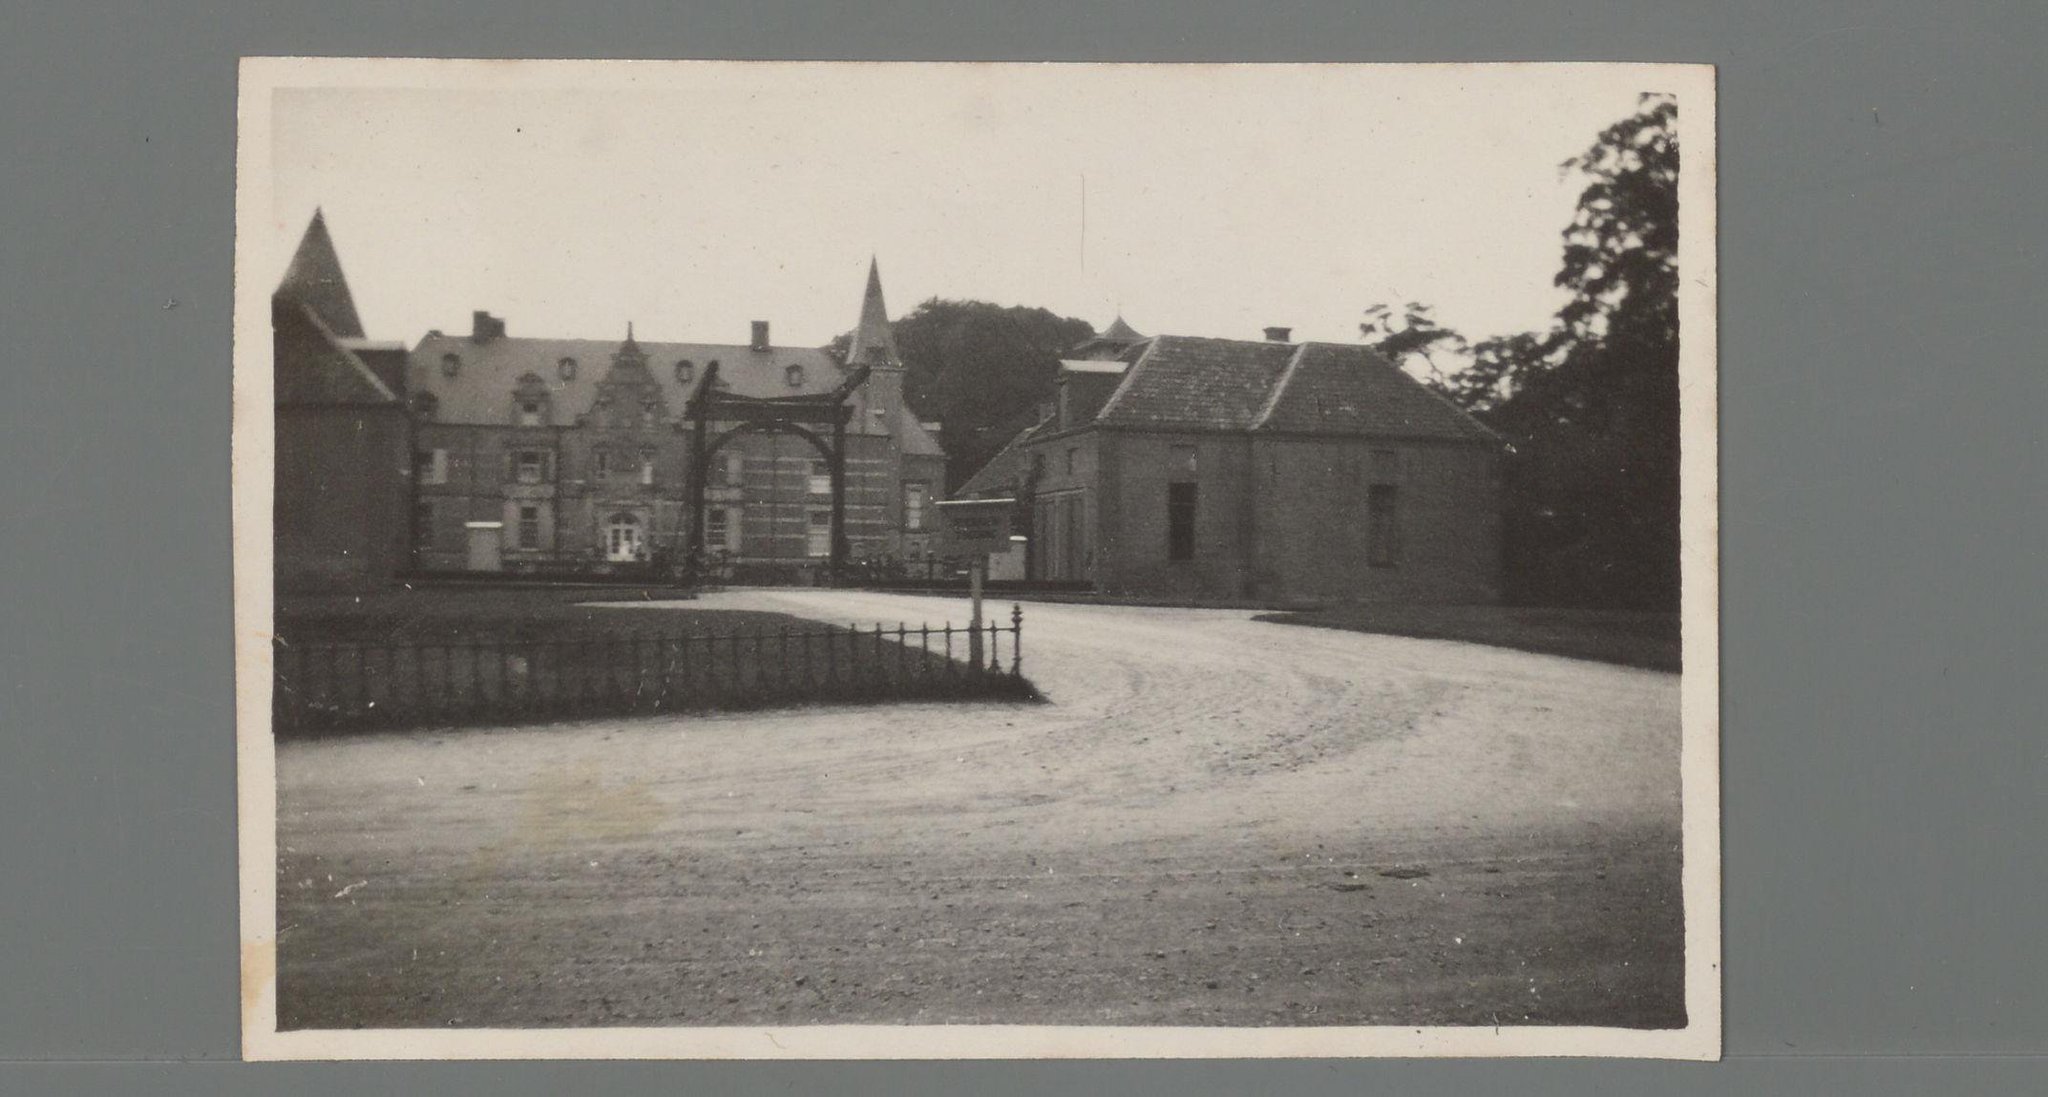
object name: photograph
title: Gezicht op kasteel Twickel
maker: Anonymous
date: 1931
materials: paper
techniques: gelatin silver print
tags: castle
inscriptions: inscription: ‘kasteel Twickel 1931’, number: ‘87’